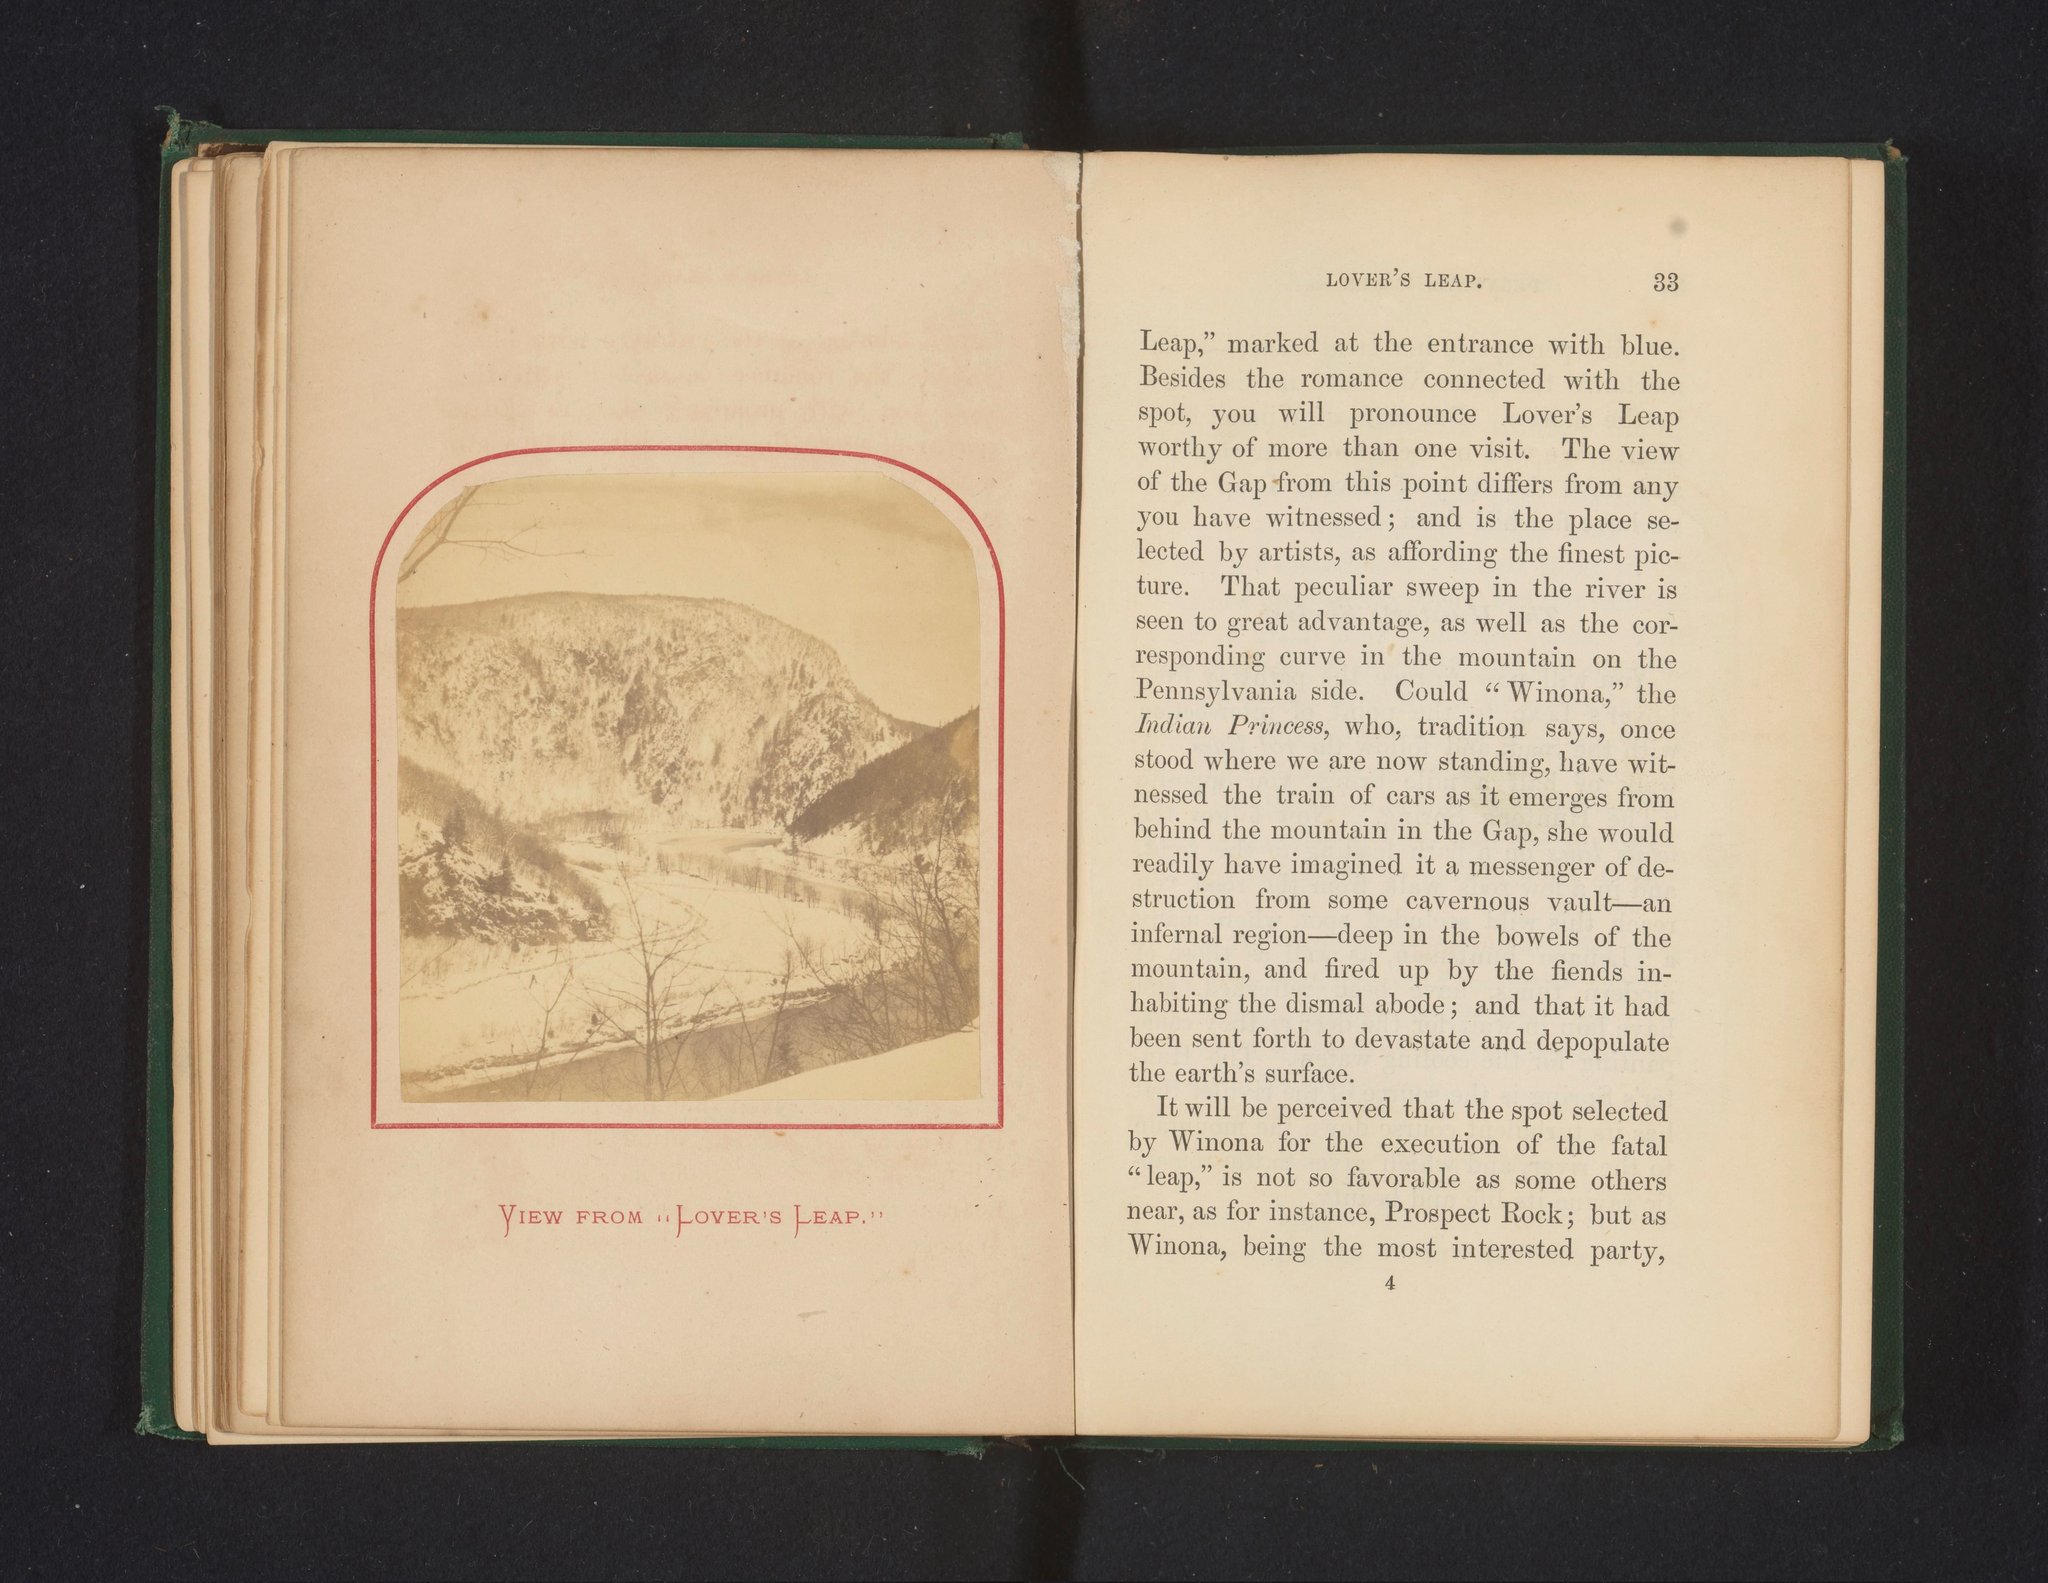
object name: page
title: View from Lover's Leap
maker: jesse a. graves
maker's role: fotograaf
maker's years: 1835-1895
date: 1862-1867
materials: photographic support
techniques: albumen print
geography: delaware water gap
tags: river, mountain-range, snow peaks